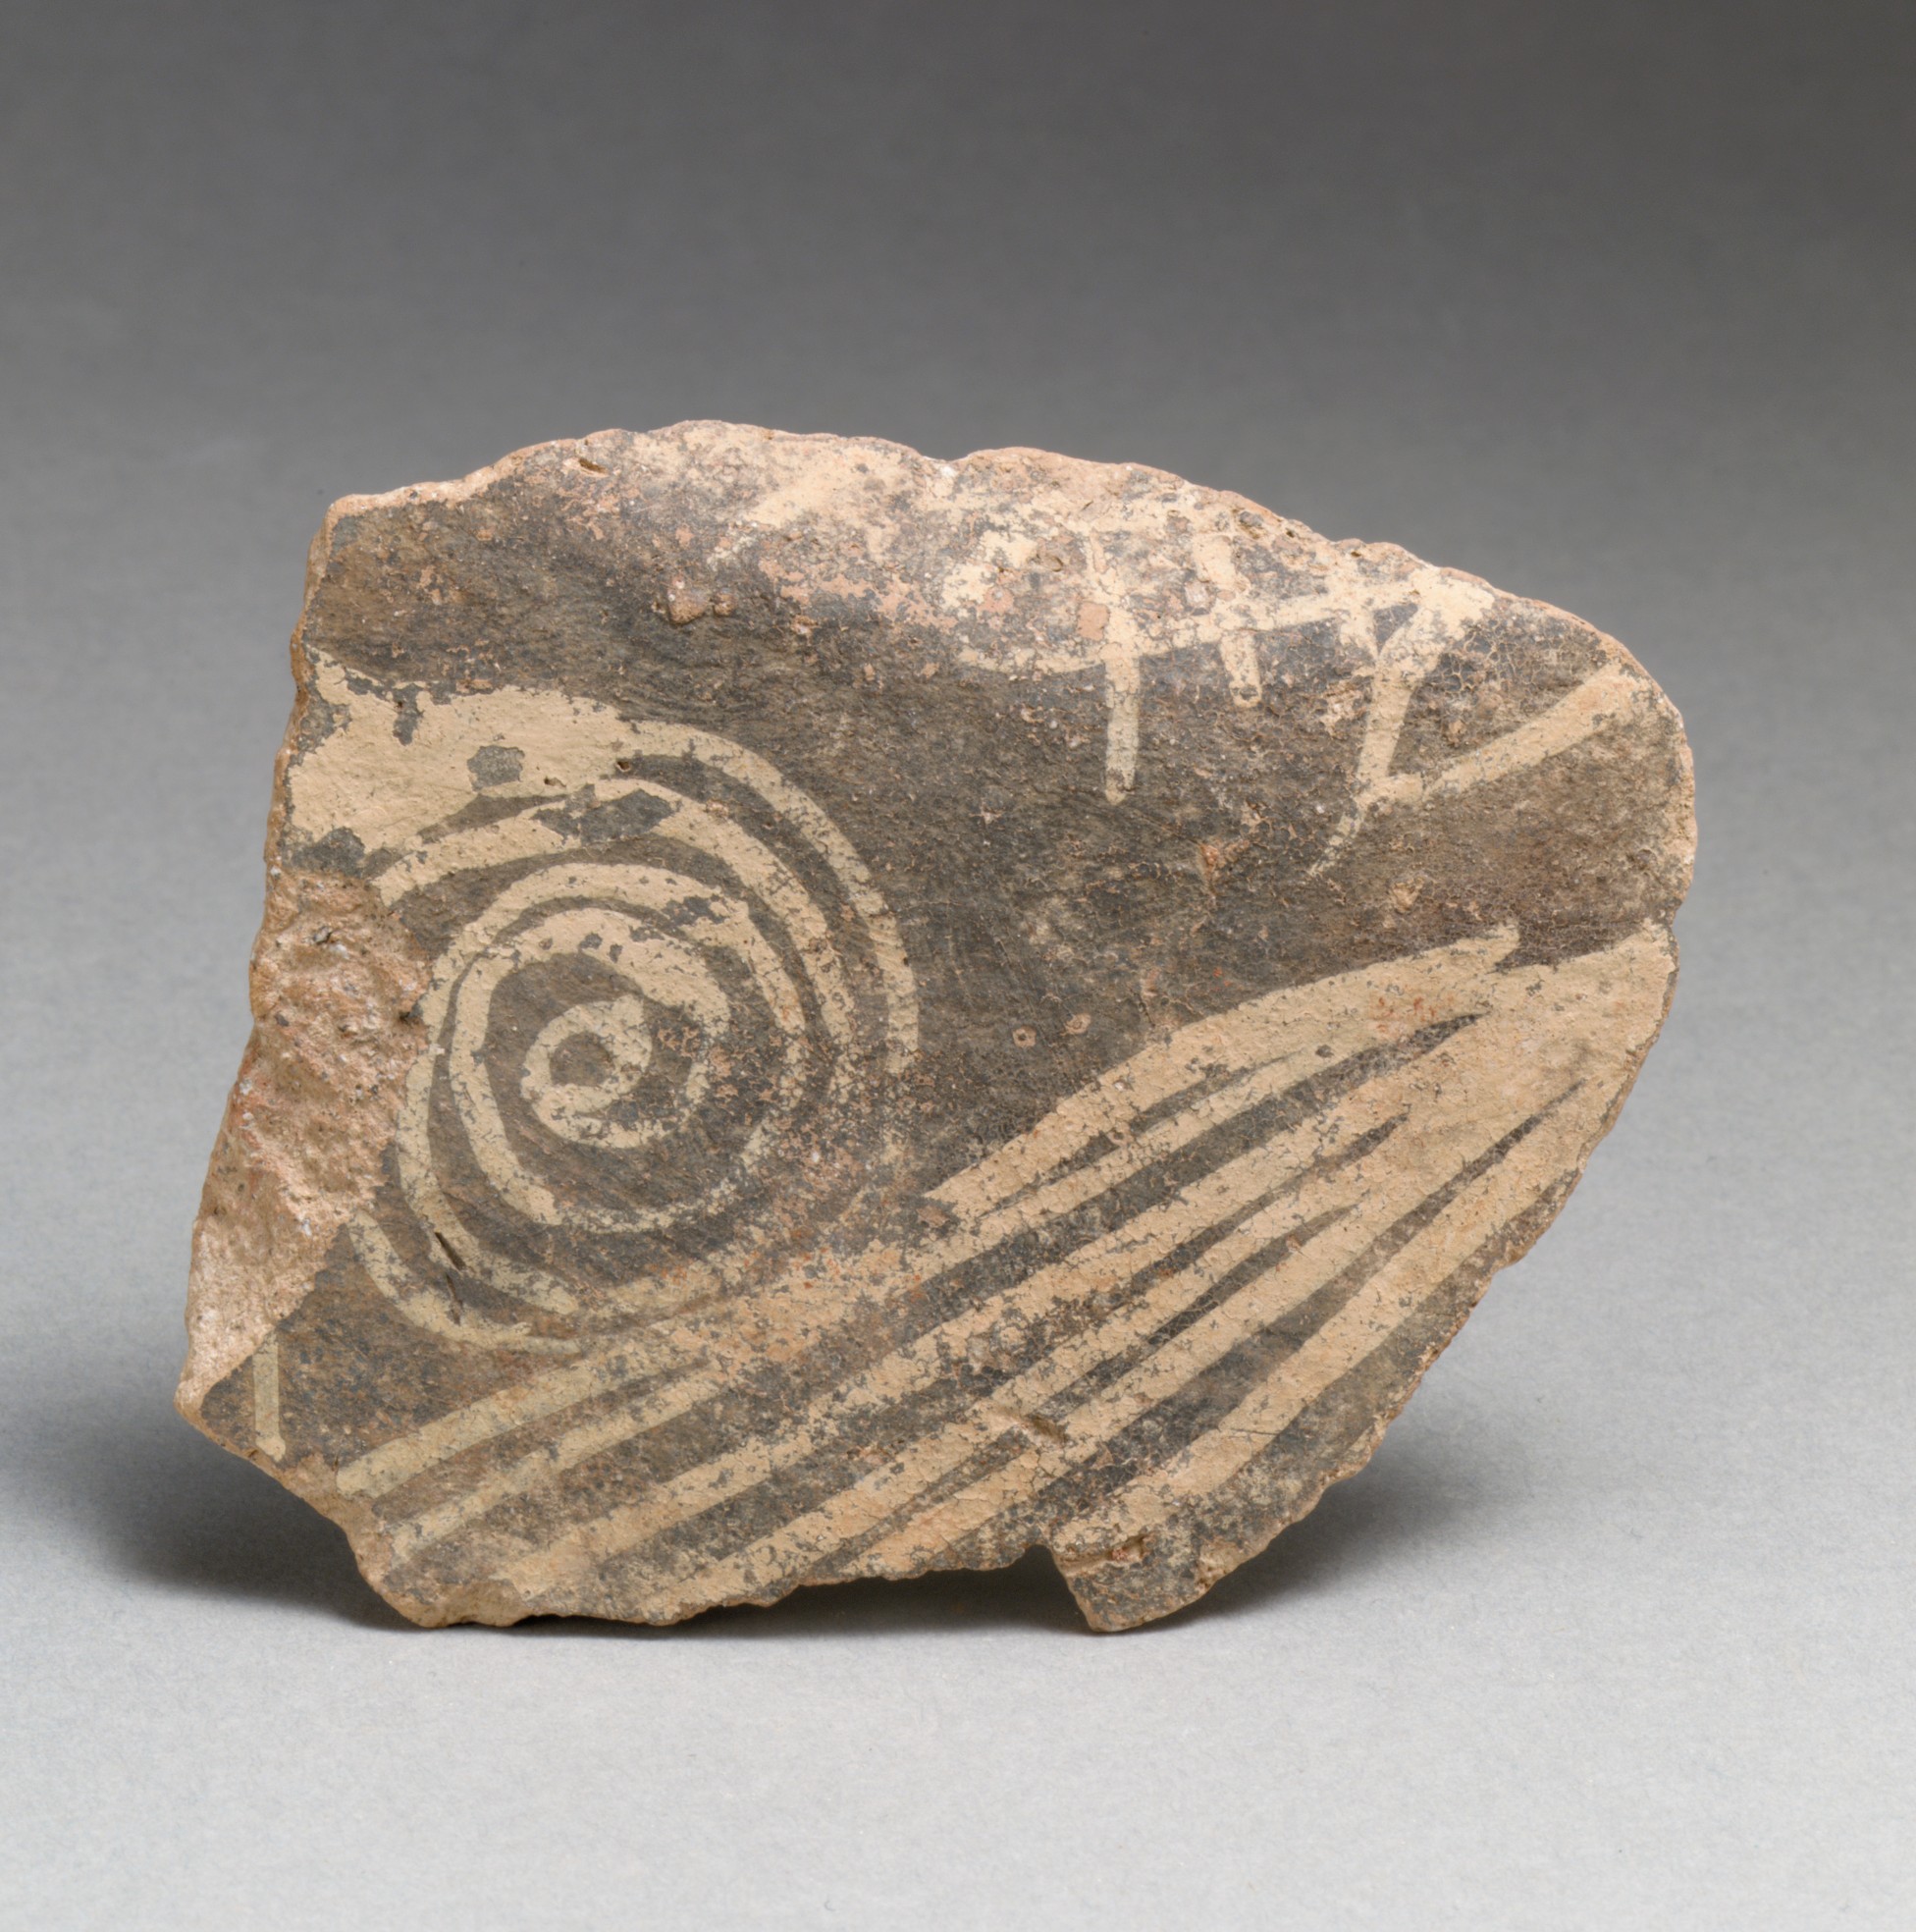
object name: vase fragment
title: Terracotta vessel fragment with spiral and linear motifs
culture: minoan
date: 2300-2100 BCE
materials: terracotta